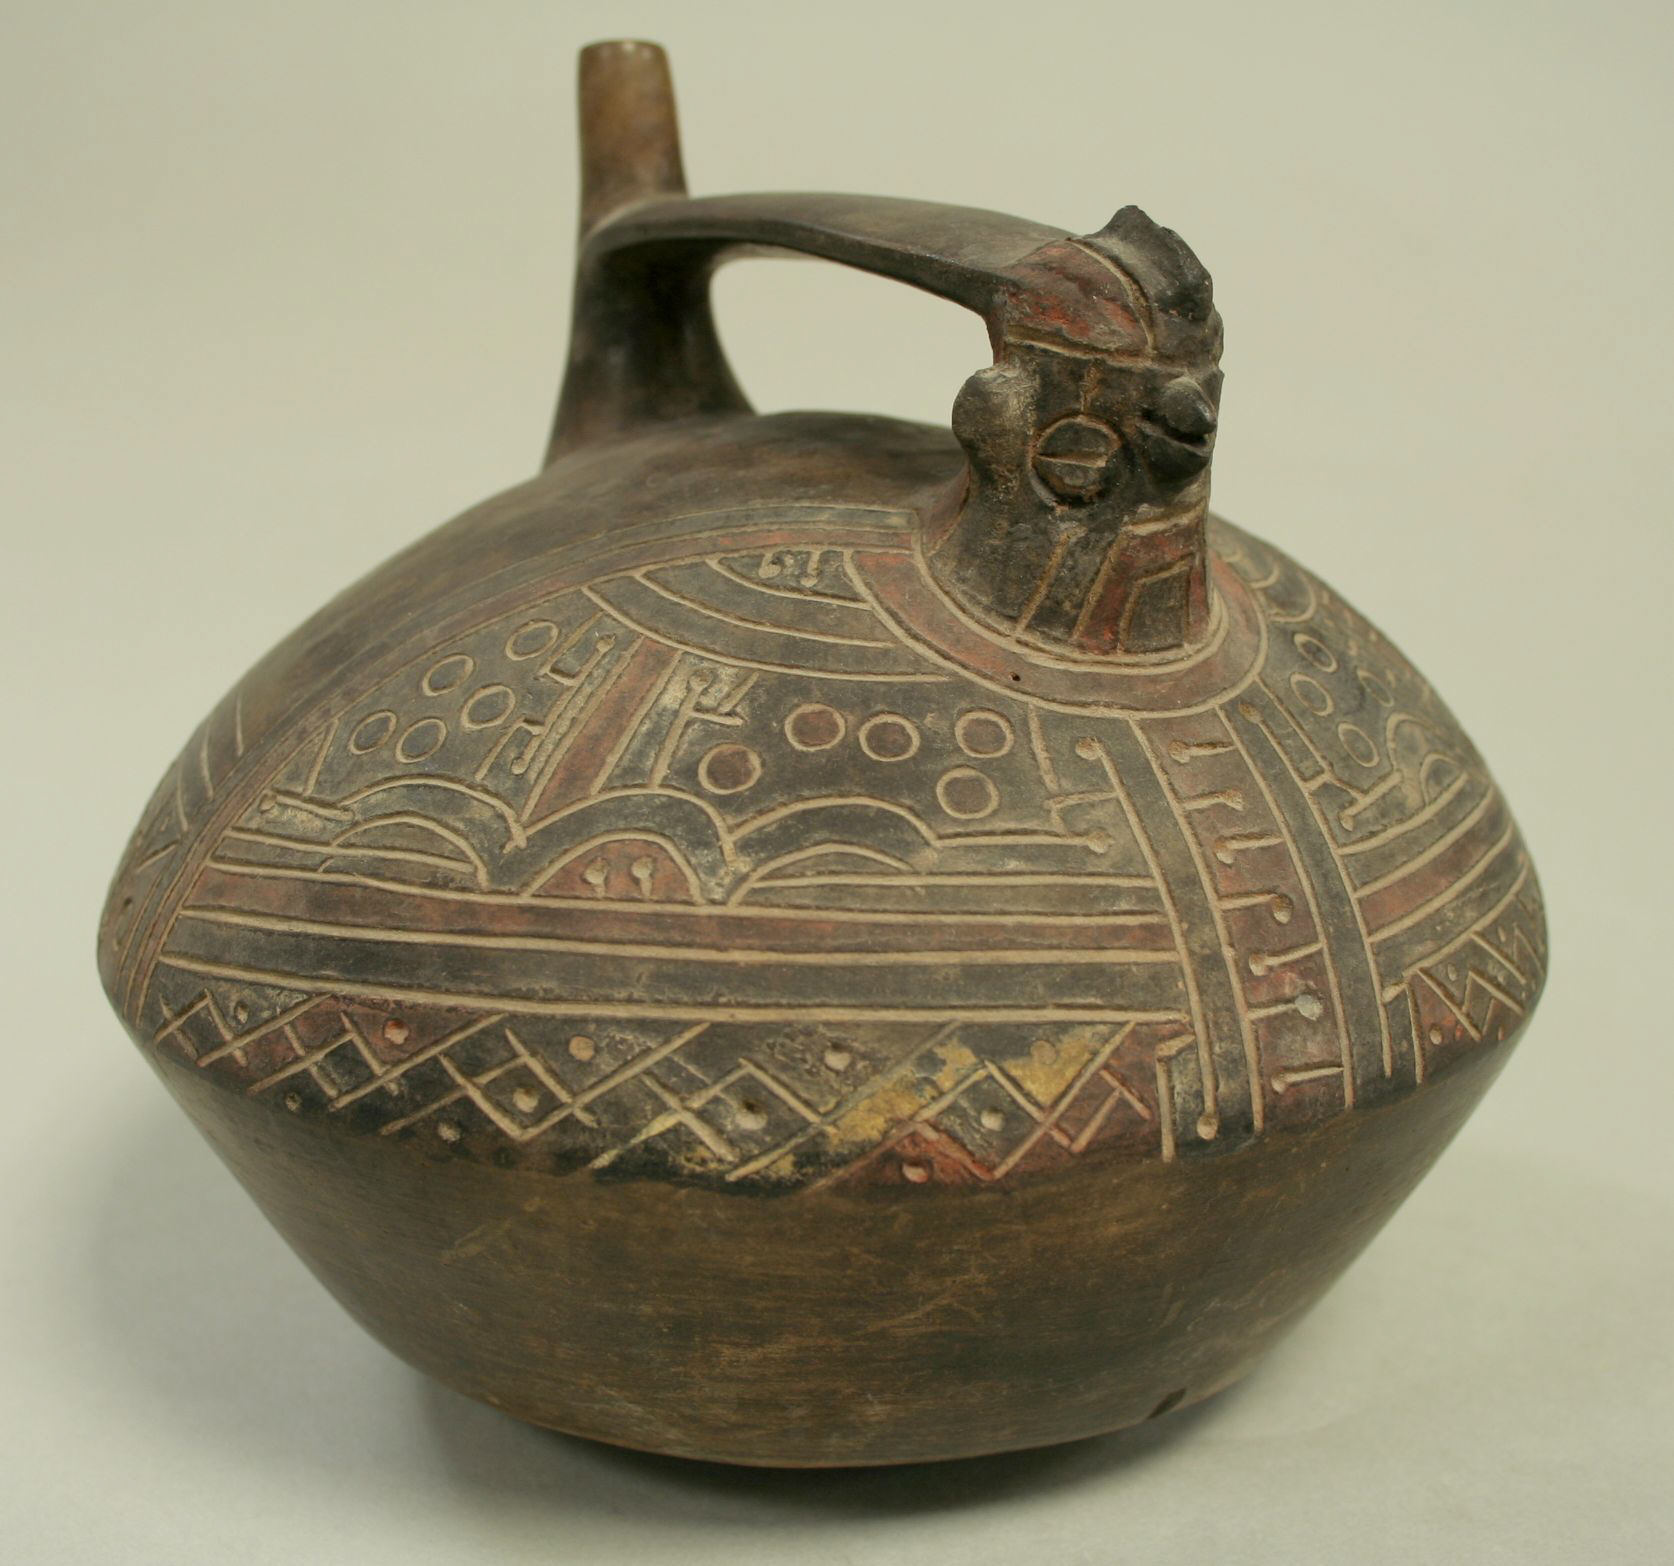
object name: bottle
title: Double Spout and Bridge Bottle with Bird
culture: paracas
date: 500-101 BCE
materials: ceramic, pigment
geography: peru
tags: birds